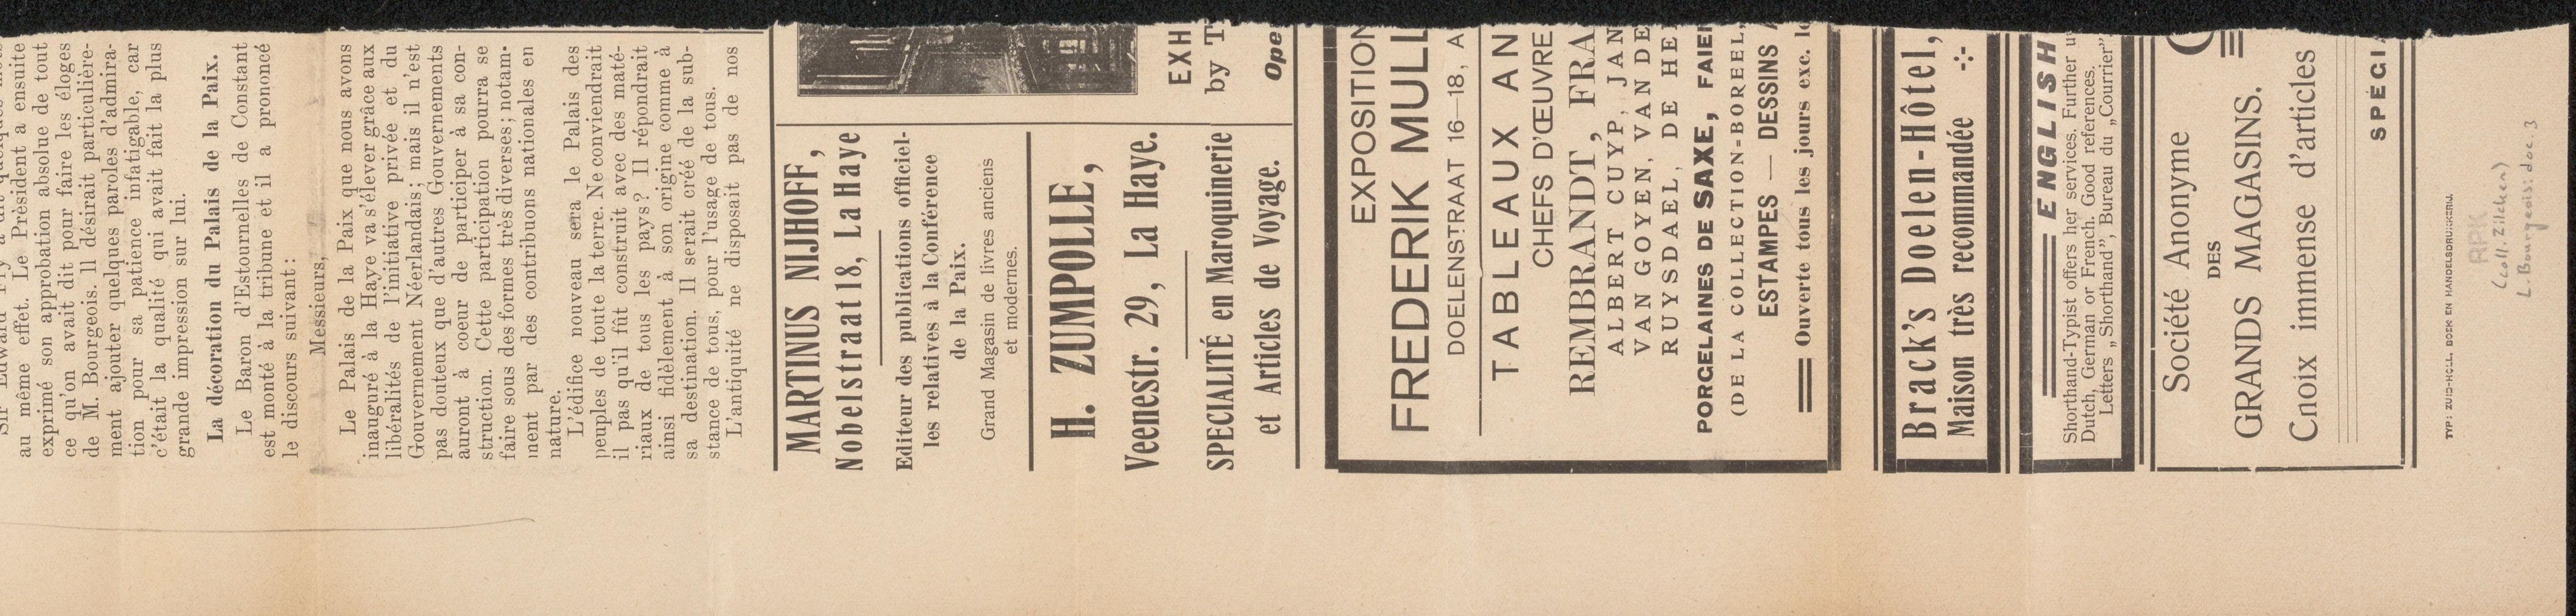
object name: visiting card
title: Artikel aan Philip Zilcken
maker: Anonymous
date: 1907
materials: paper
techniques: printing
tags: the hague, painter, draughtsman, philip zilcken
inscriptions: collector's mark: ‘RPK’